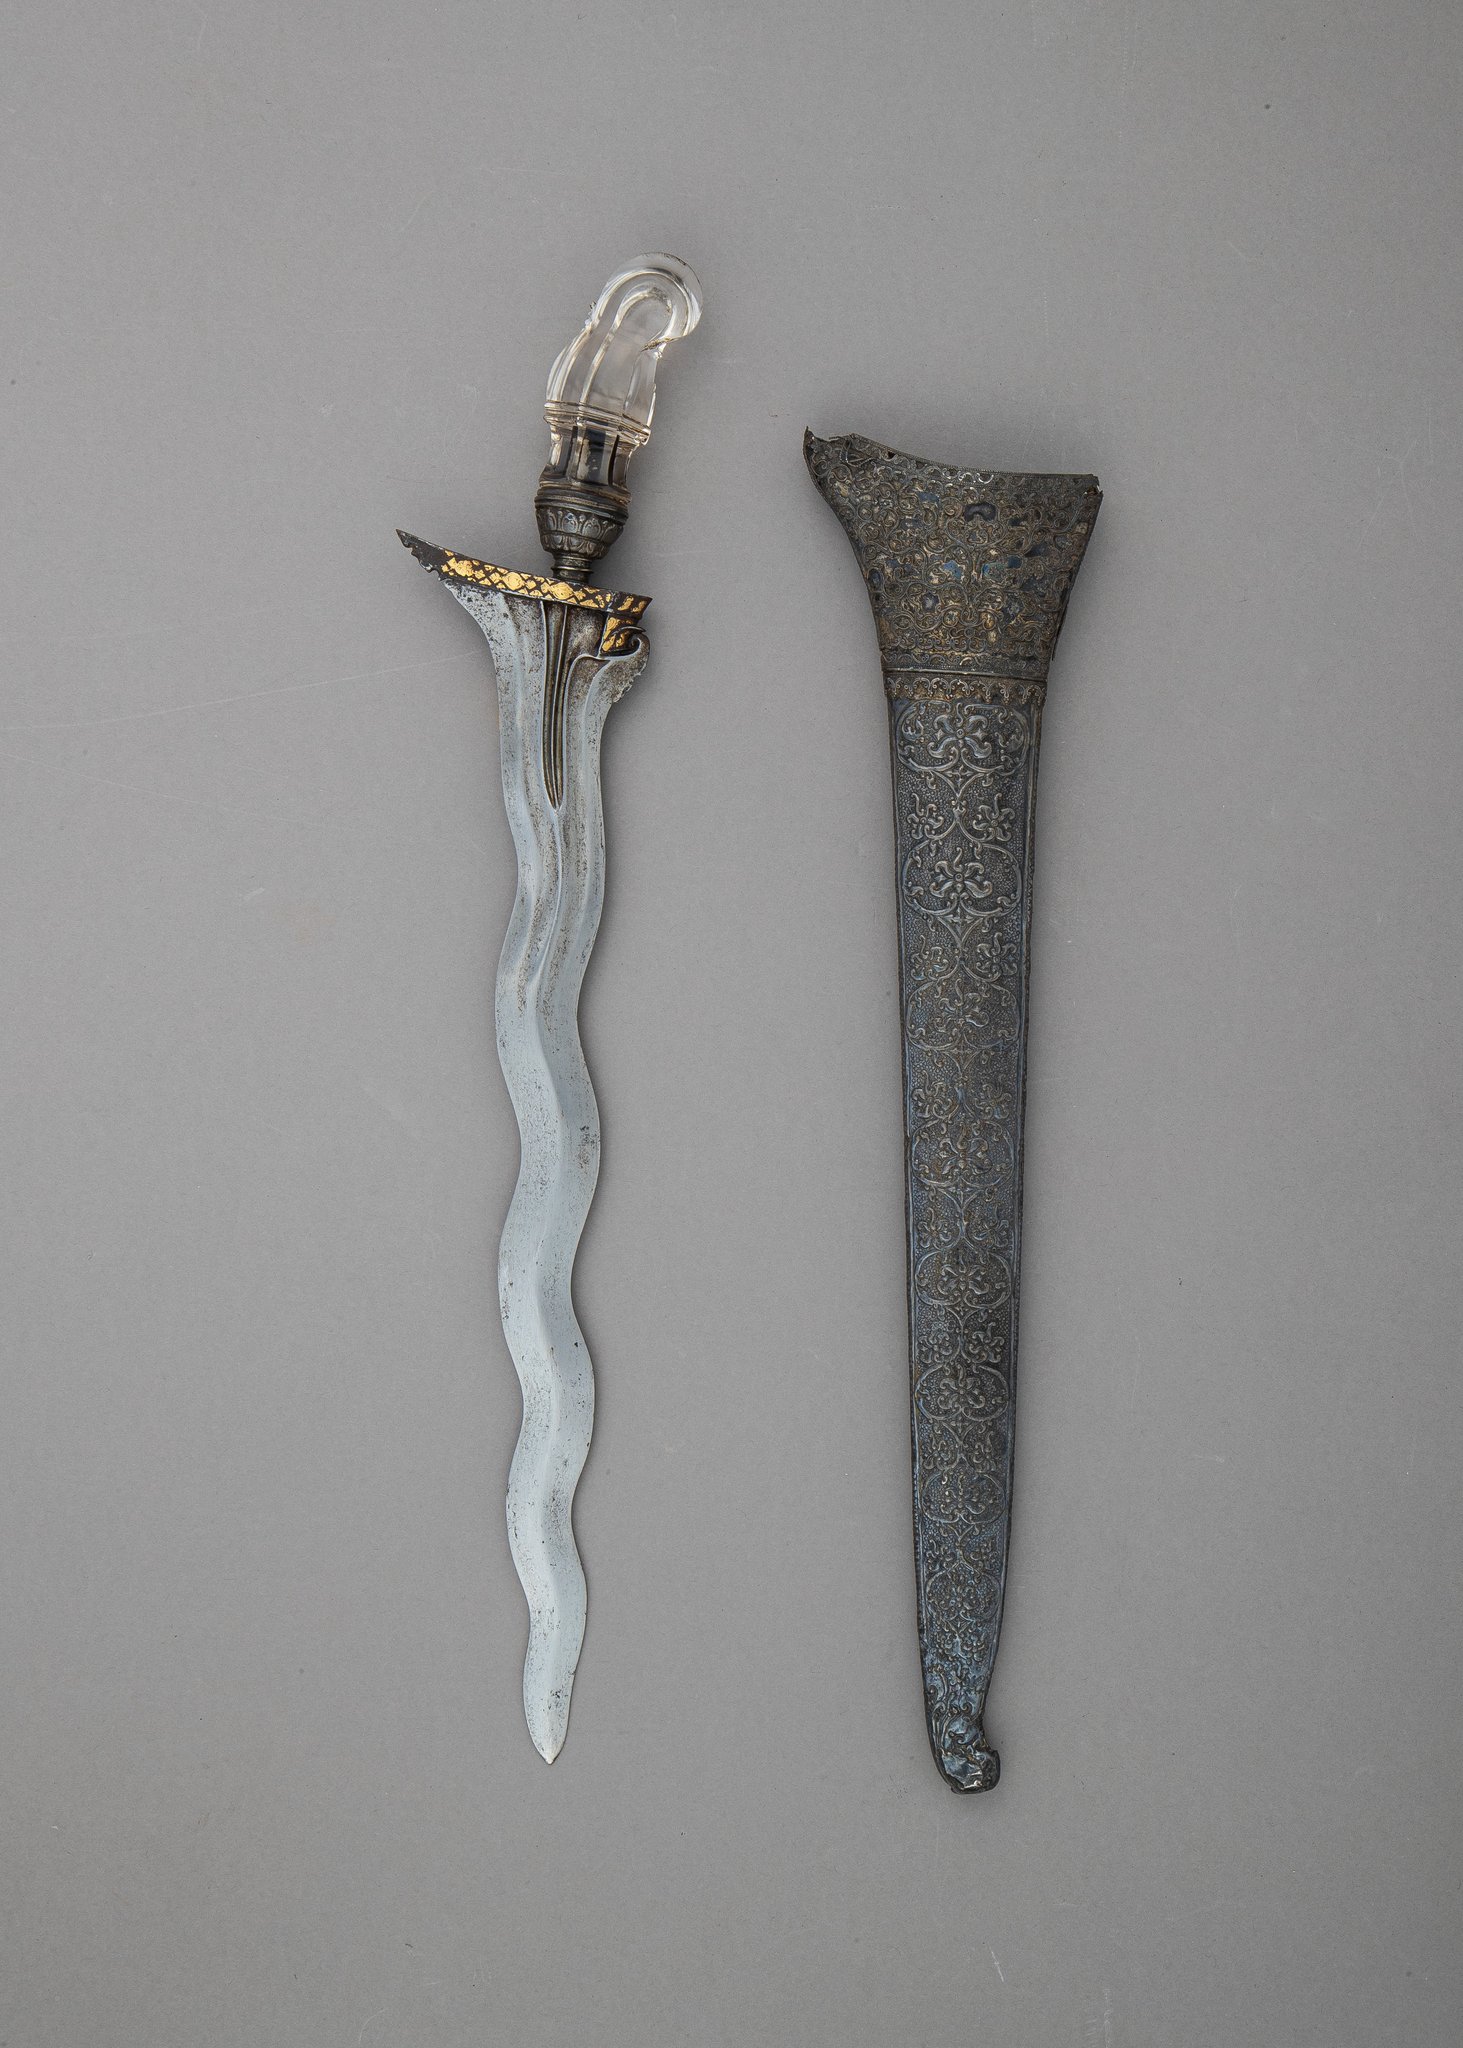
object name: kris with sheath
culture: javanese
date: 1501-1900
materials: crystal, gold, silver, steel, wood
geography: indonesia